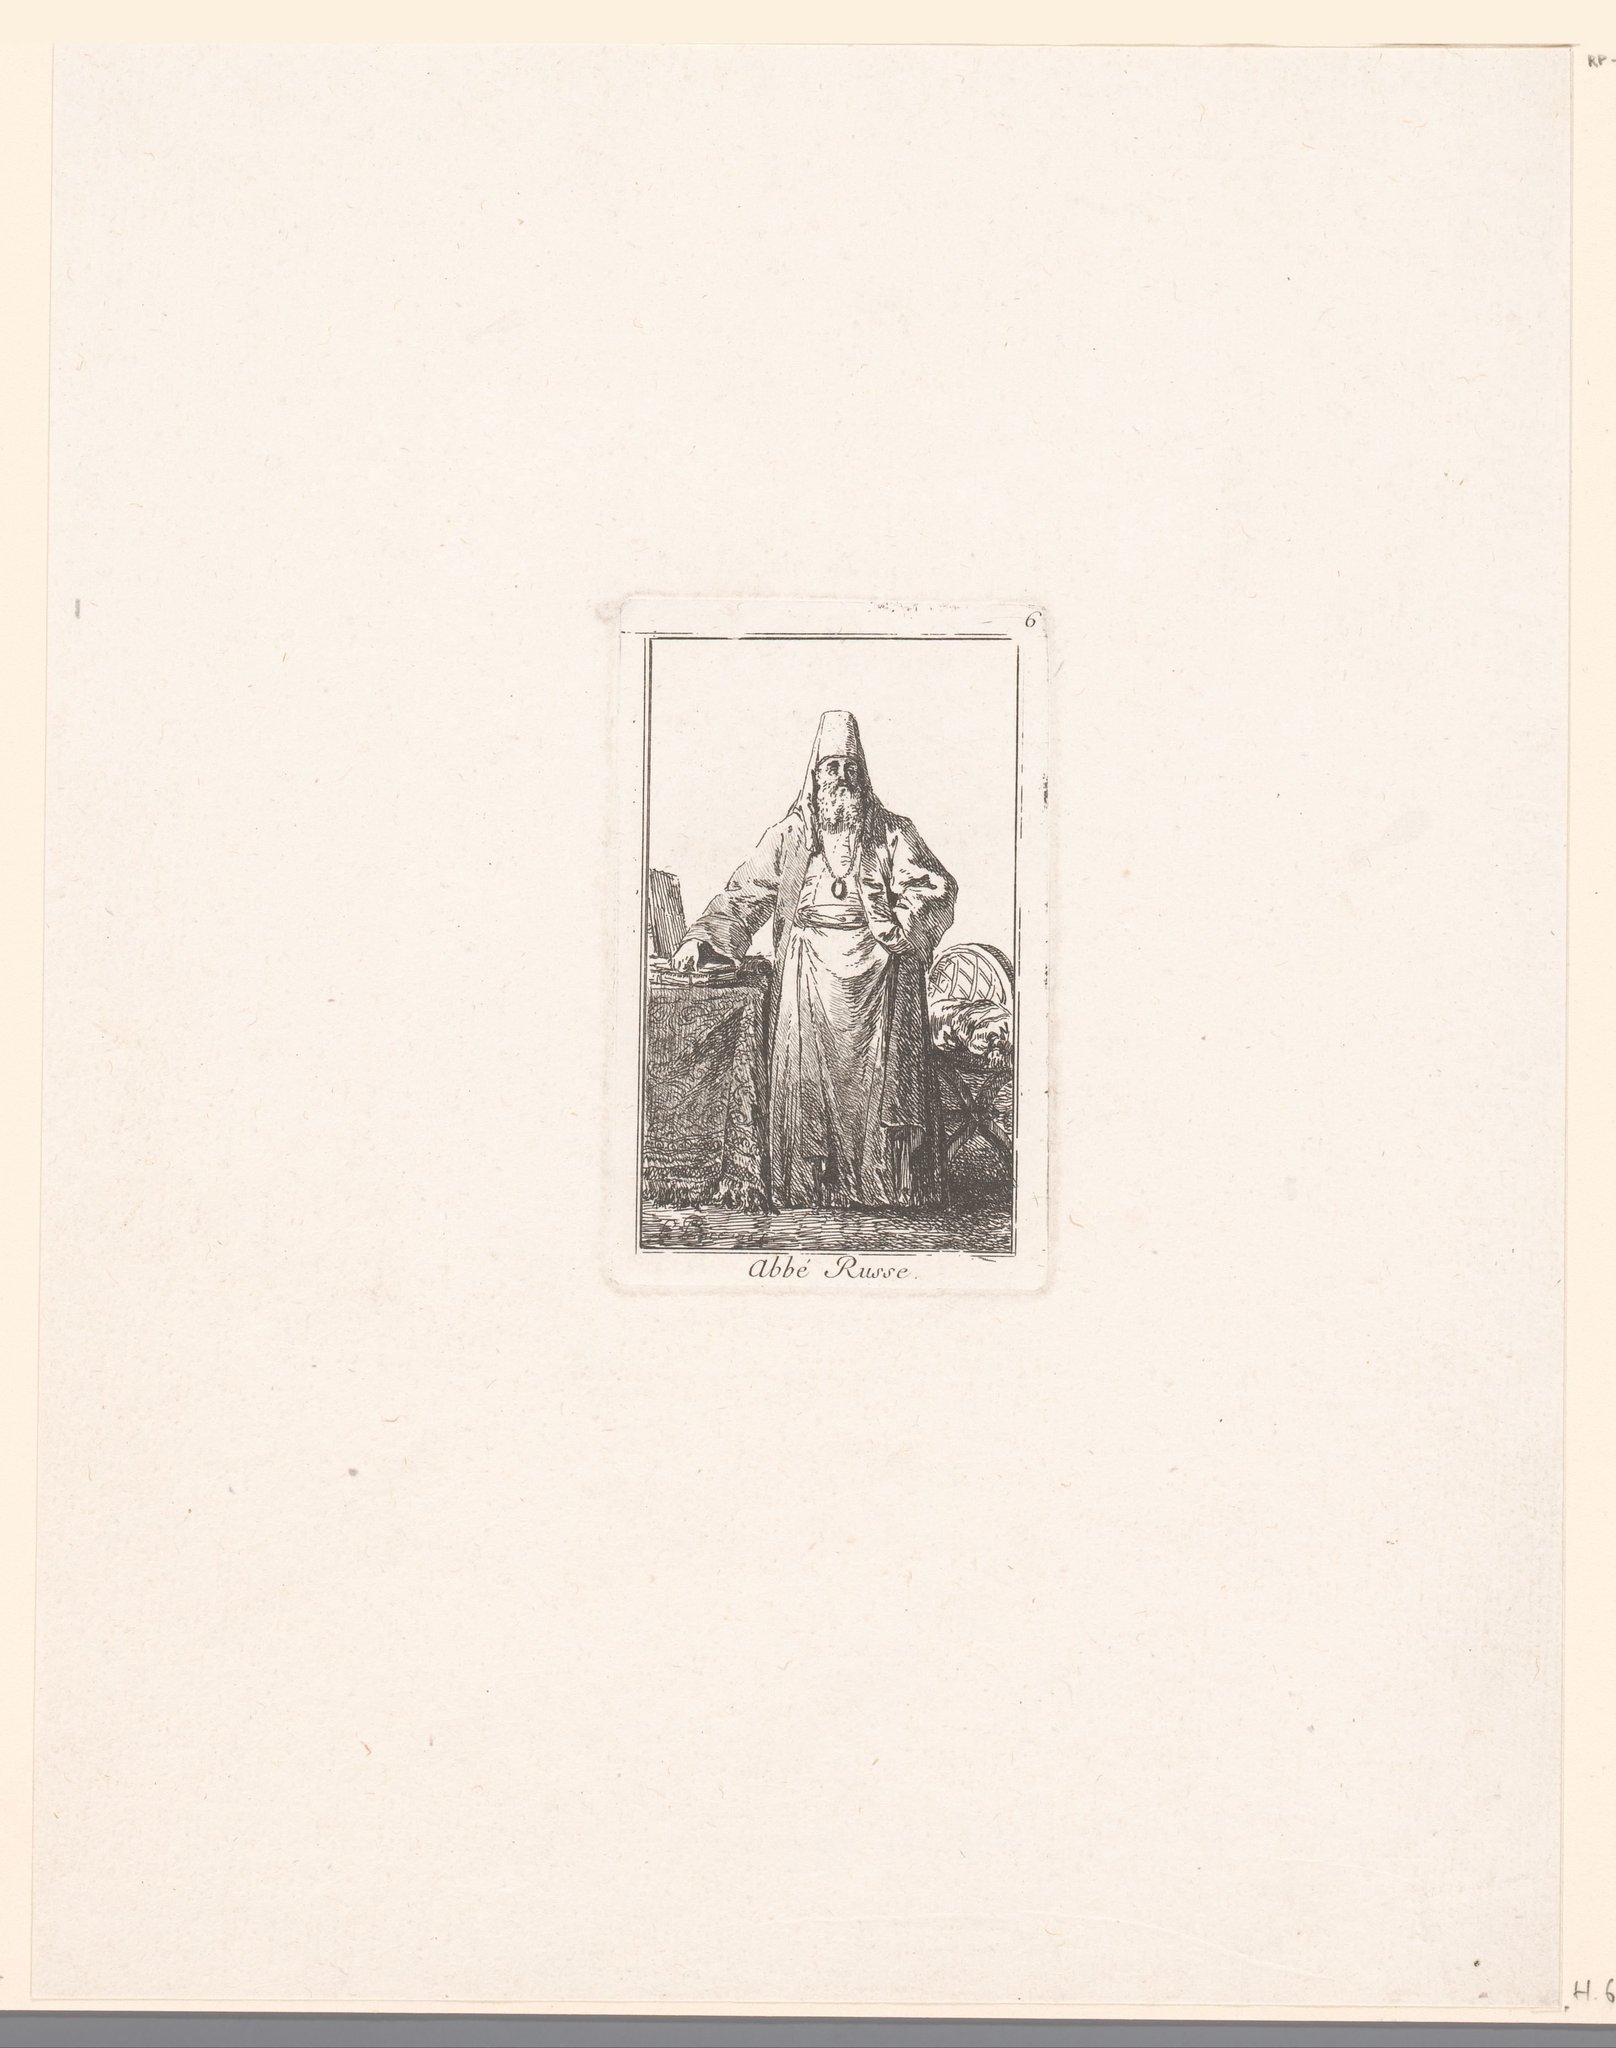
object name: print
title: Kostuums van figuren met verschillende nationaliteiten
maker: jean baptist leprince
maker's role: draughtsman, print maker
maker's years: 1734-1781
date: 1765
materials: paper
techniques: etching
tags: hierarchy of jurisdiction ~ eastern, greek and russian orthodox churches, folk costume, regional costume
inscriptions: date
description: Maakt deel uit van een zesdelige serie met figuren in kostuums van verschillende nationaliteiten.